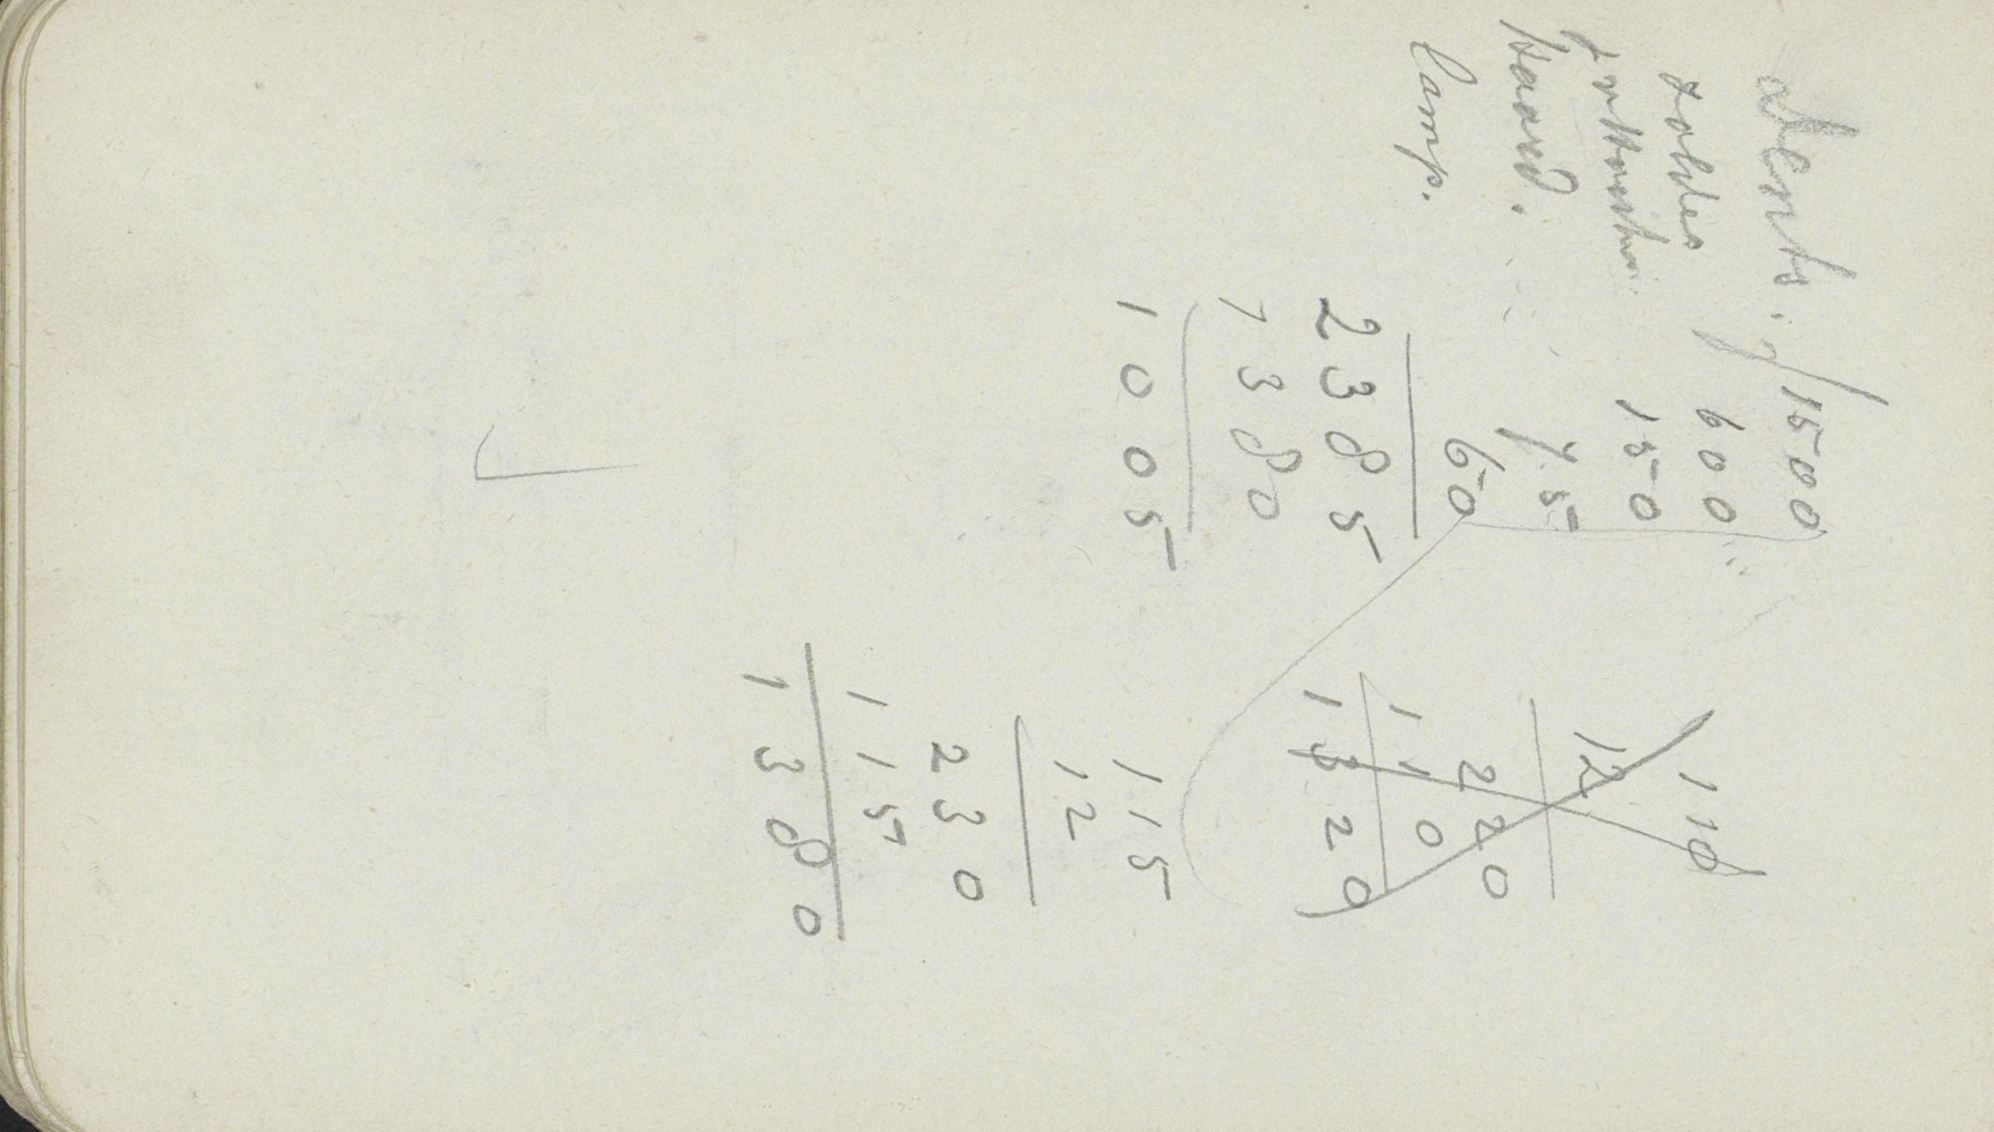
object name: sketchbook leaf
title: Berekeningen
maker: carel adolph lion cachet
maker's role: draughtsman, print maker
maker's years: 1864-1945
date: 1905-1906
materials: paper, pencil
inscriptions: annotation: ‘[...]’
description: Blad 28 verso uit een schetsboek met 34 bladen.